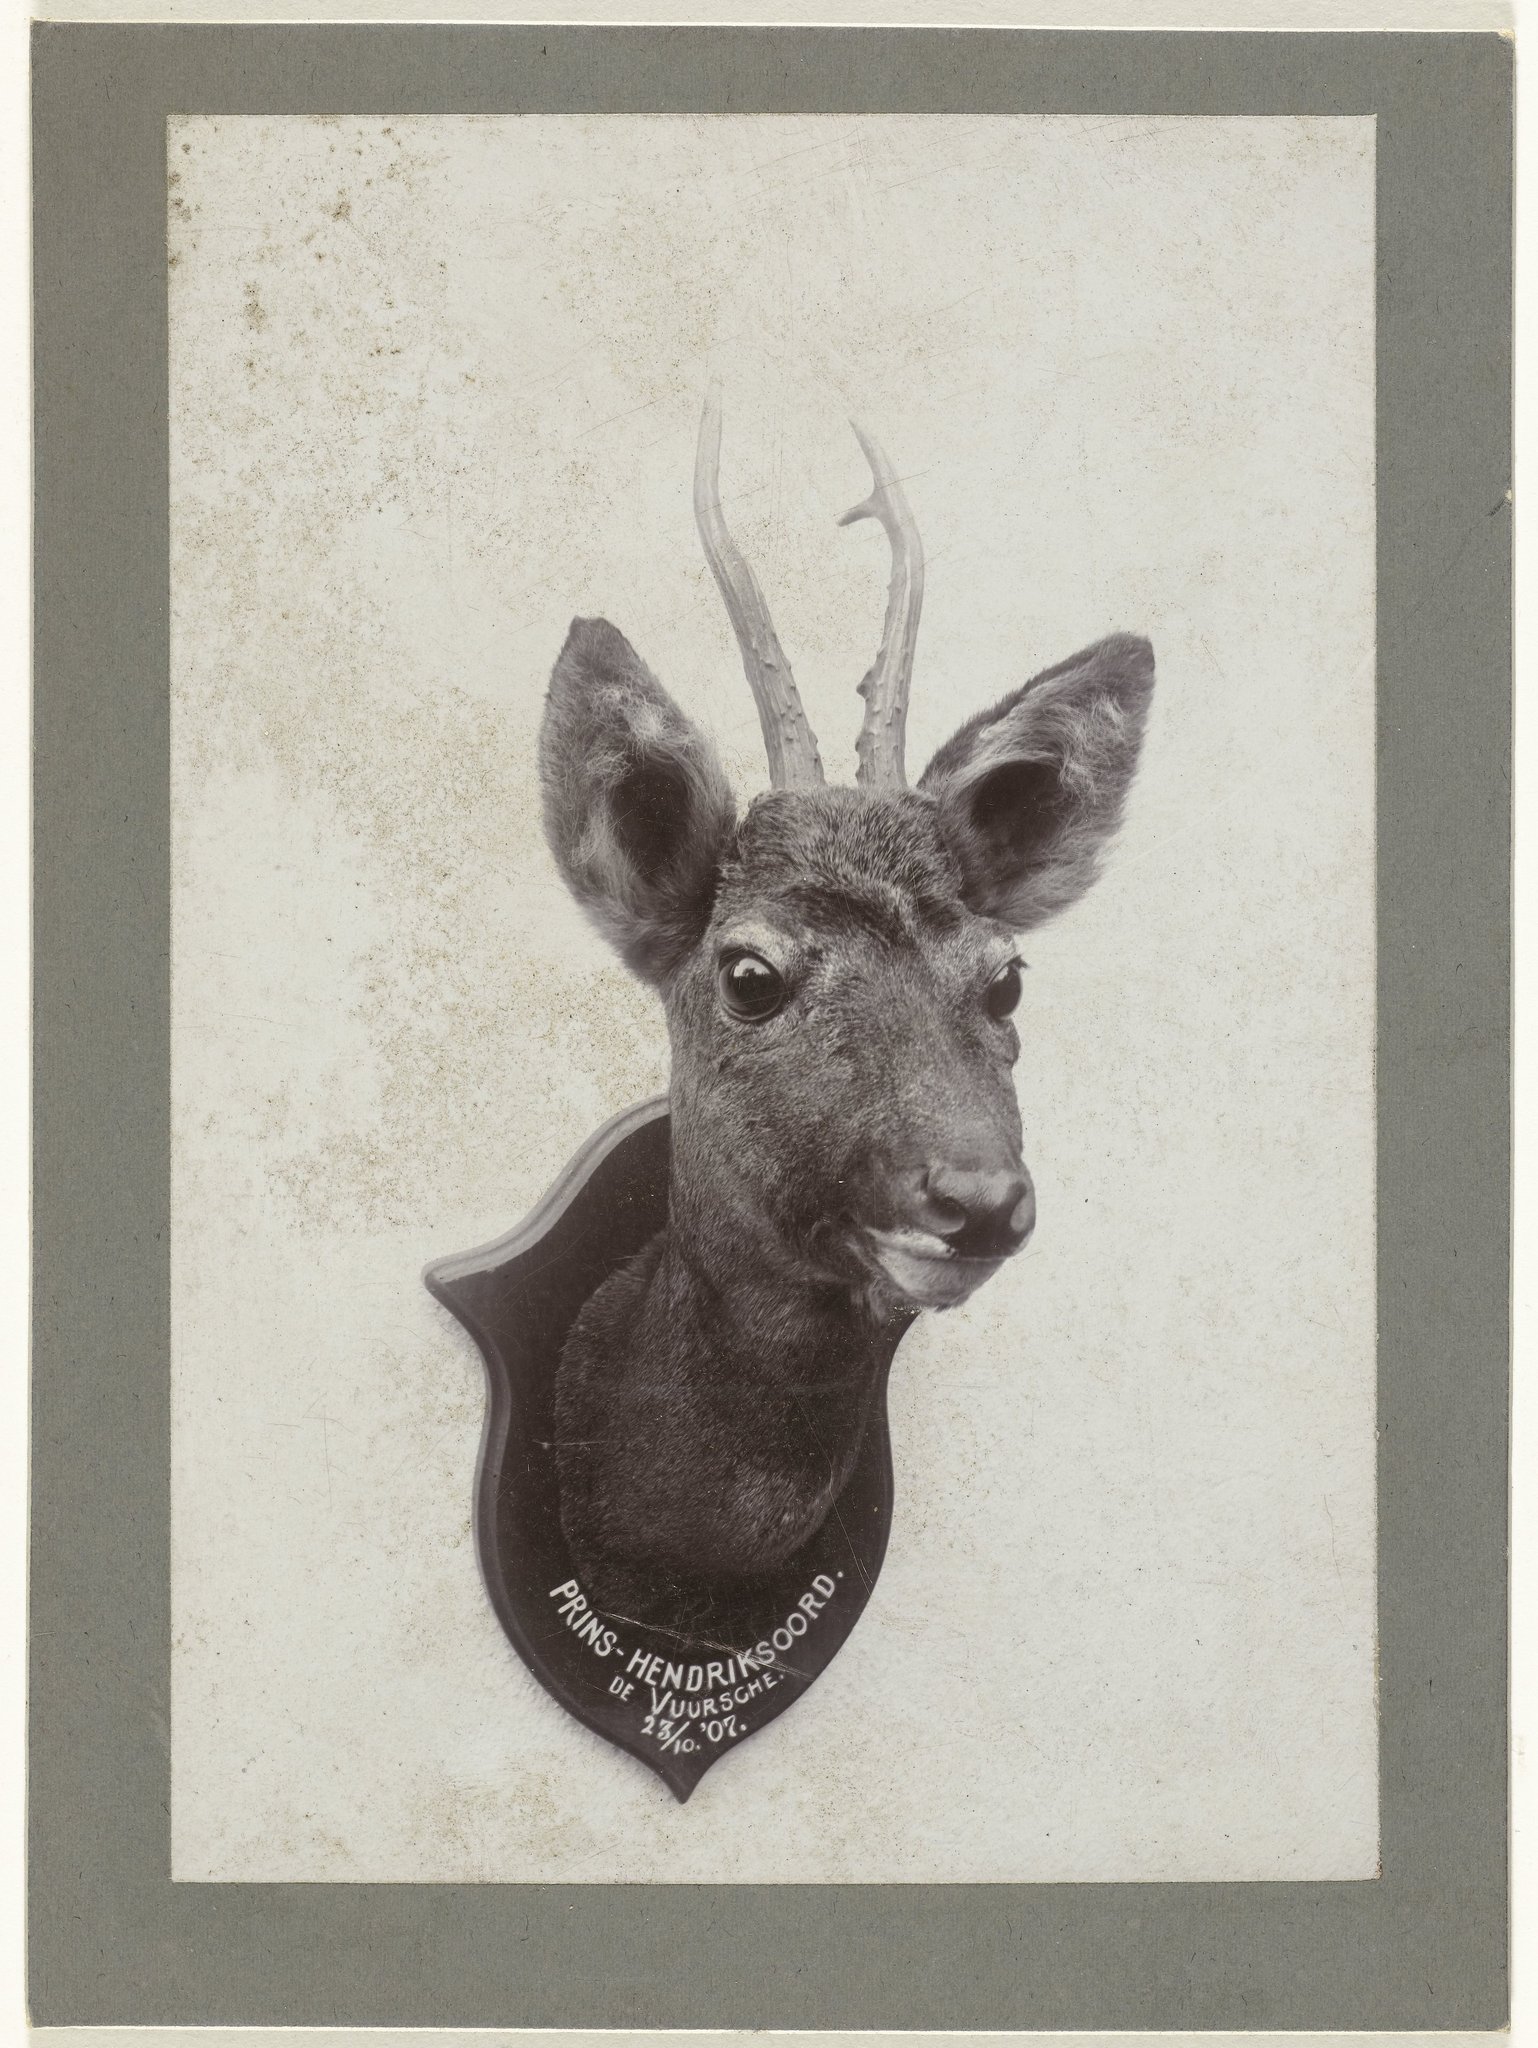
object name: photograph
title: Jachttrofee van een hert, geschoten op 23 oktober 1907 in Prins-Hendriksoord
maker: henry pauw van wieldrecht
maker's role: fotograaf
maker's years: 1863-1912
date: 1910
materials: cardboard, photographic support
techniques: collodion silver print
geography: netherlands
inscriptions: annotation: ‘No 3735. / 1910.’